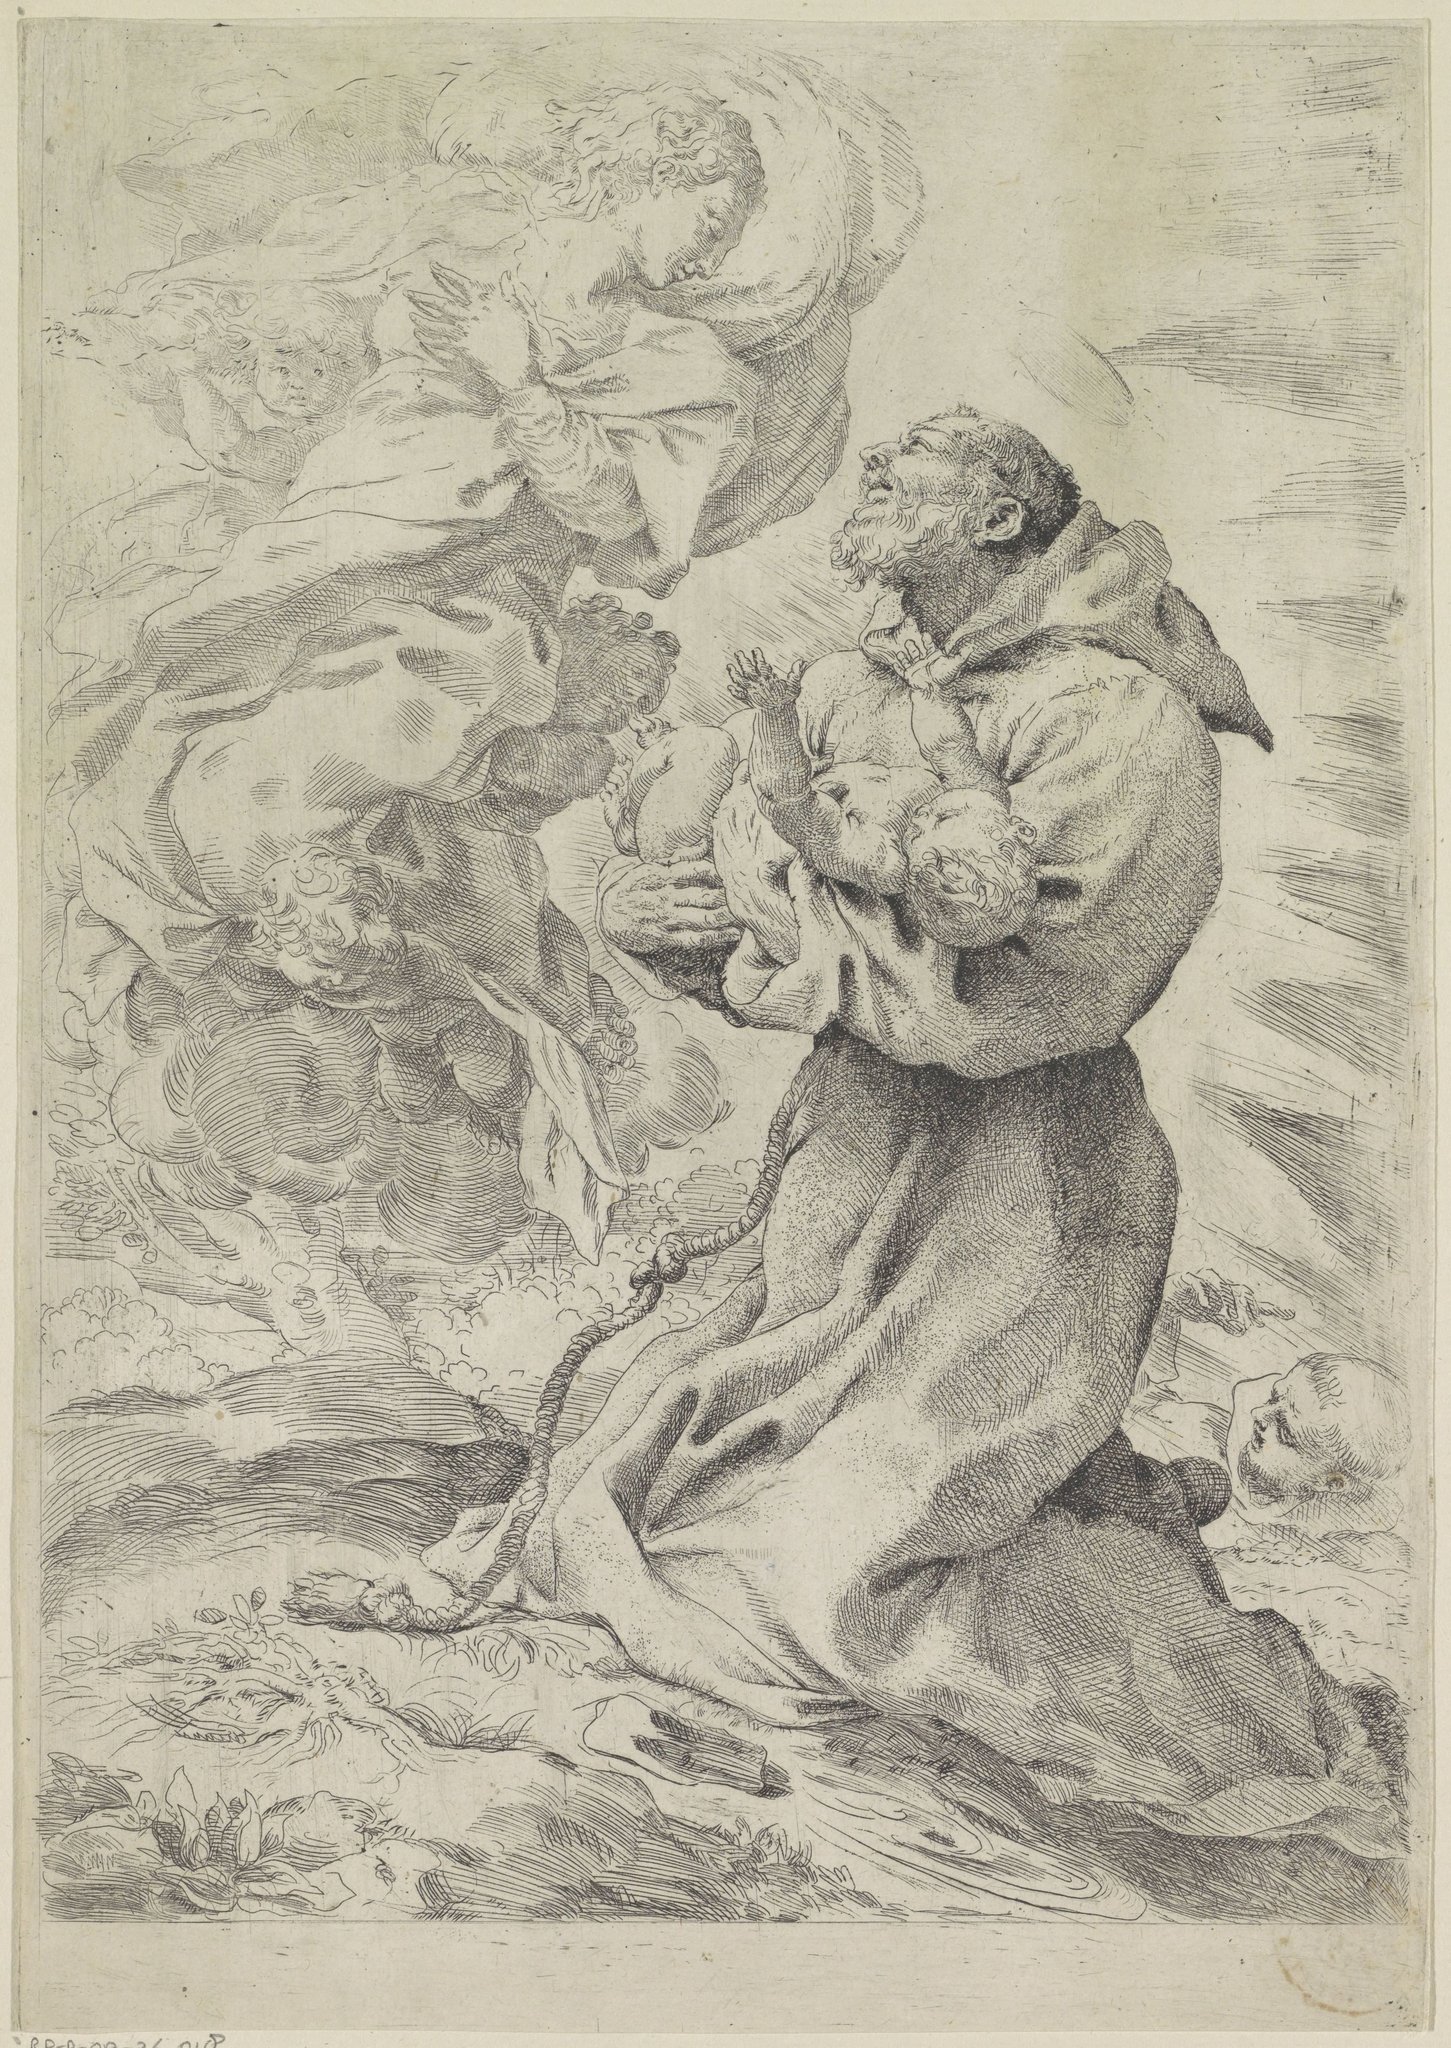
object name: print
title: De heilige Franciscus van Assisi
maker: pietro faccini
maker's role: draughtsman, print maker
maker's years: 1562-1602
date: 1572-1602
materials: paper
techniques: etching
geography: italy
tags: founder of the order of friars minor (franciscans), francis(cus) of assisi; possible attributes: book, crucifix, lily, skull, stigmata, the virgin mary handing over the infant christ to st. francis of assisi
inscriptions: collector's mark: Lugt 240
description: Maria verschijnt aan de heilige Franciscus van Assisi en geeft hem het Christuskind. Franciscus zit geknield met het Kind in zijn armen.